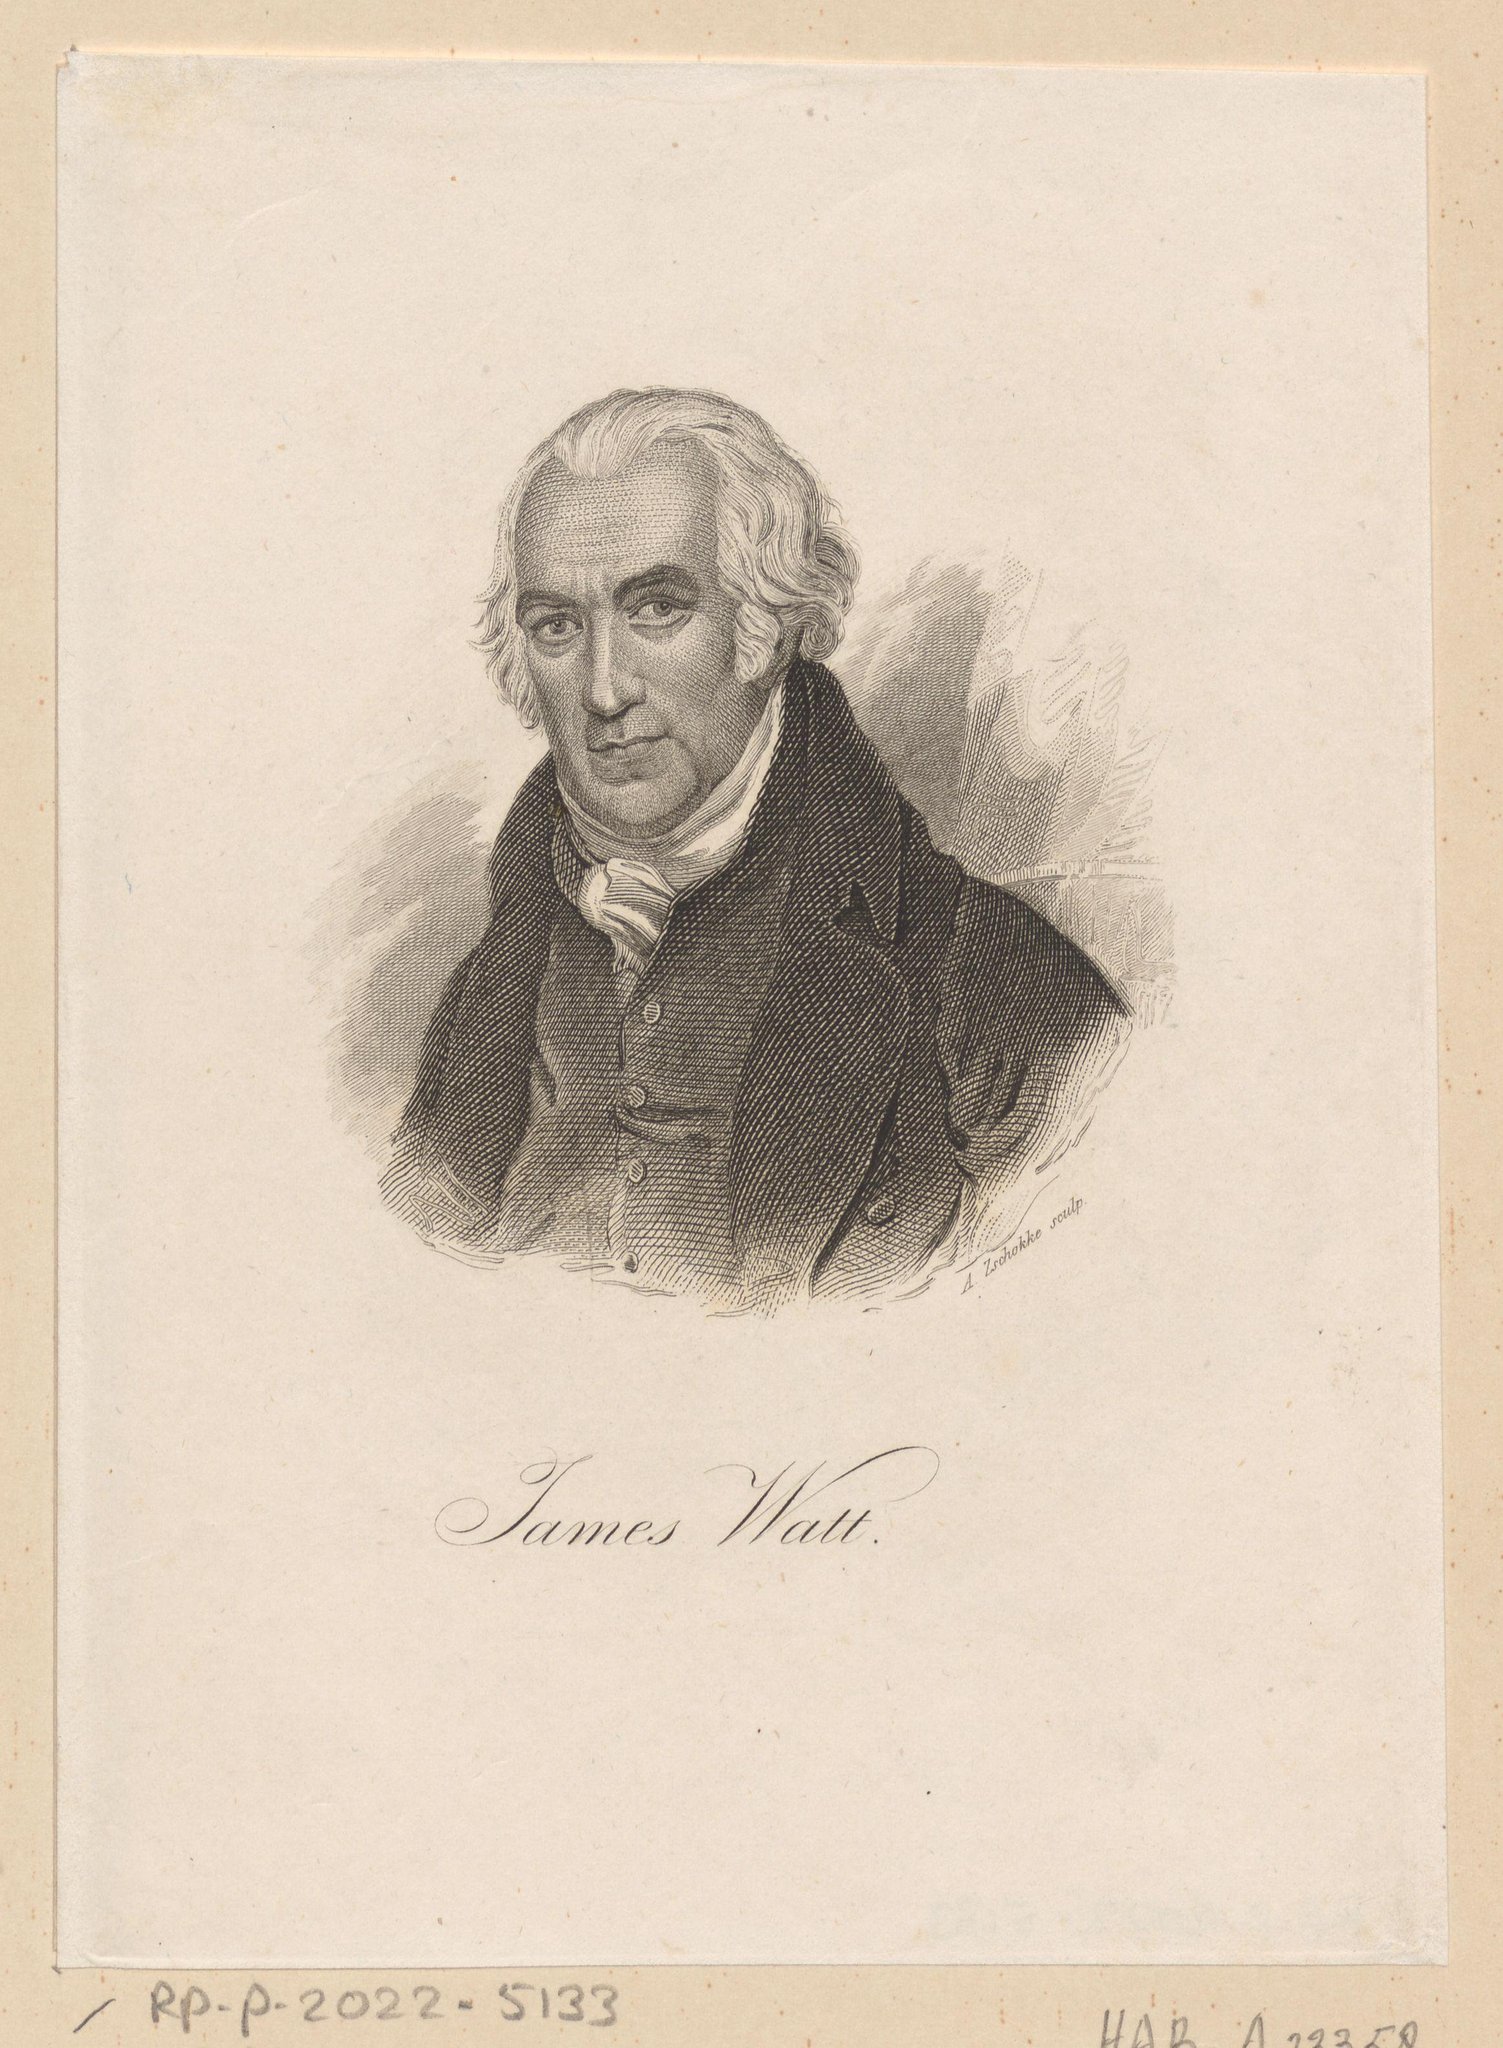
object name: print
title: Portret van James Watt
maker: alexander gottfried zschokke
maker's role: print maker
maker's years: 1811-1859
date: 1821-1859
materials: paper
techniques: engraving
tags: historical persons